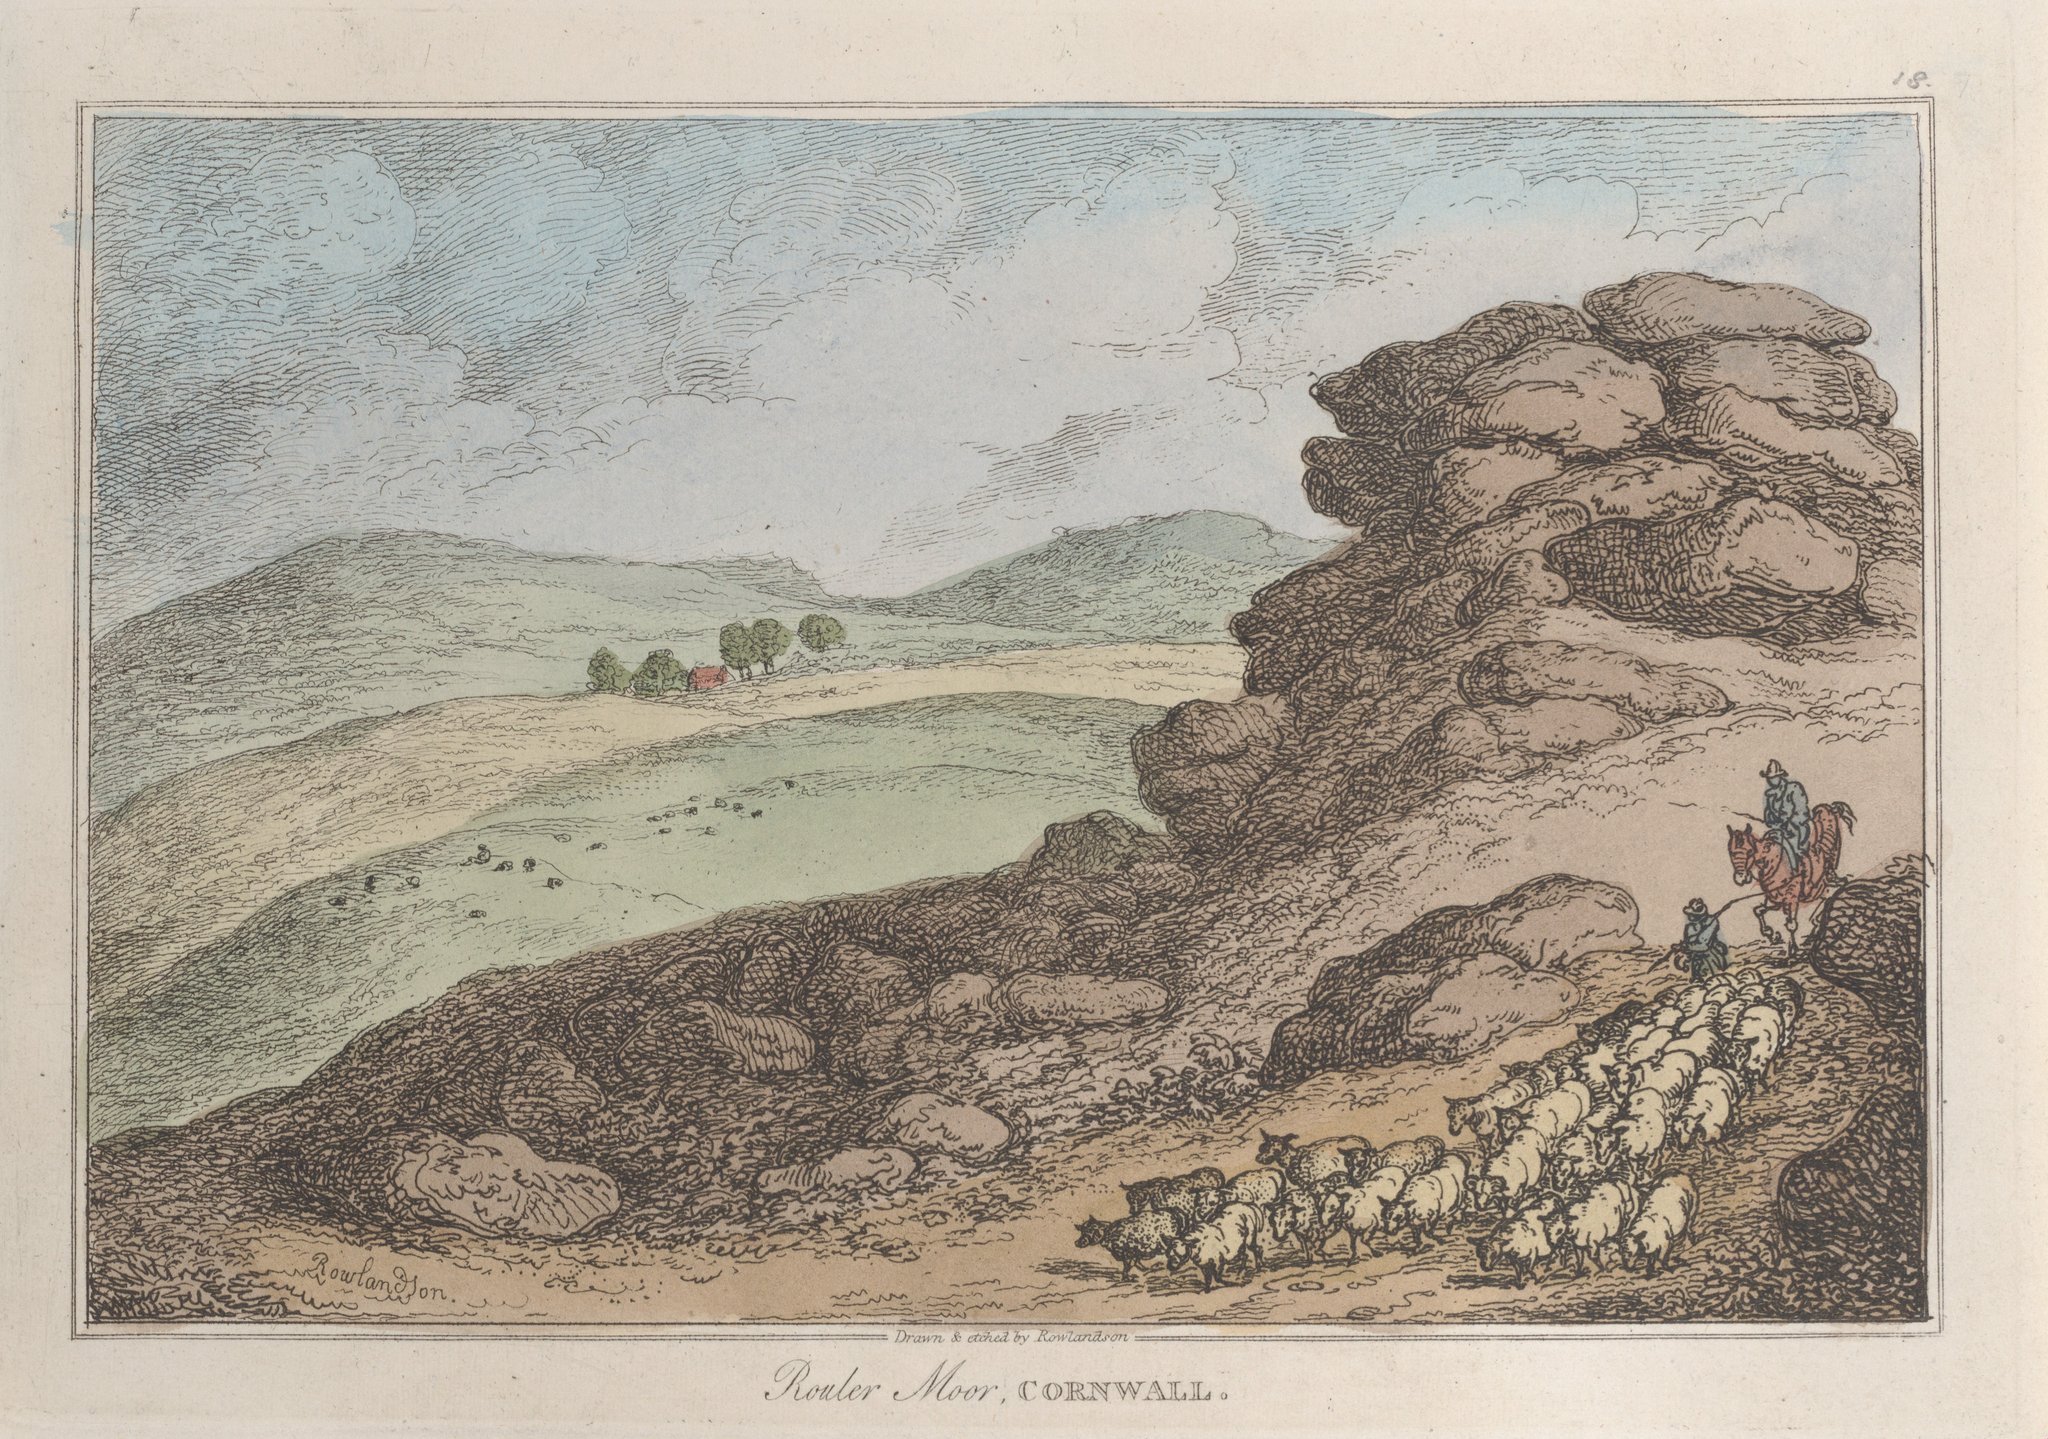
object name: print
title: Rouler Moor, Cornwall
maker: thomas rowlandson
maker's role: artist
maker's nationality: british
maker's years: 1757-1827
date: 1822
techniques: etching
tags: landscapes